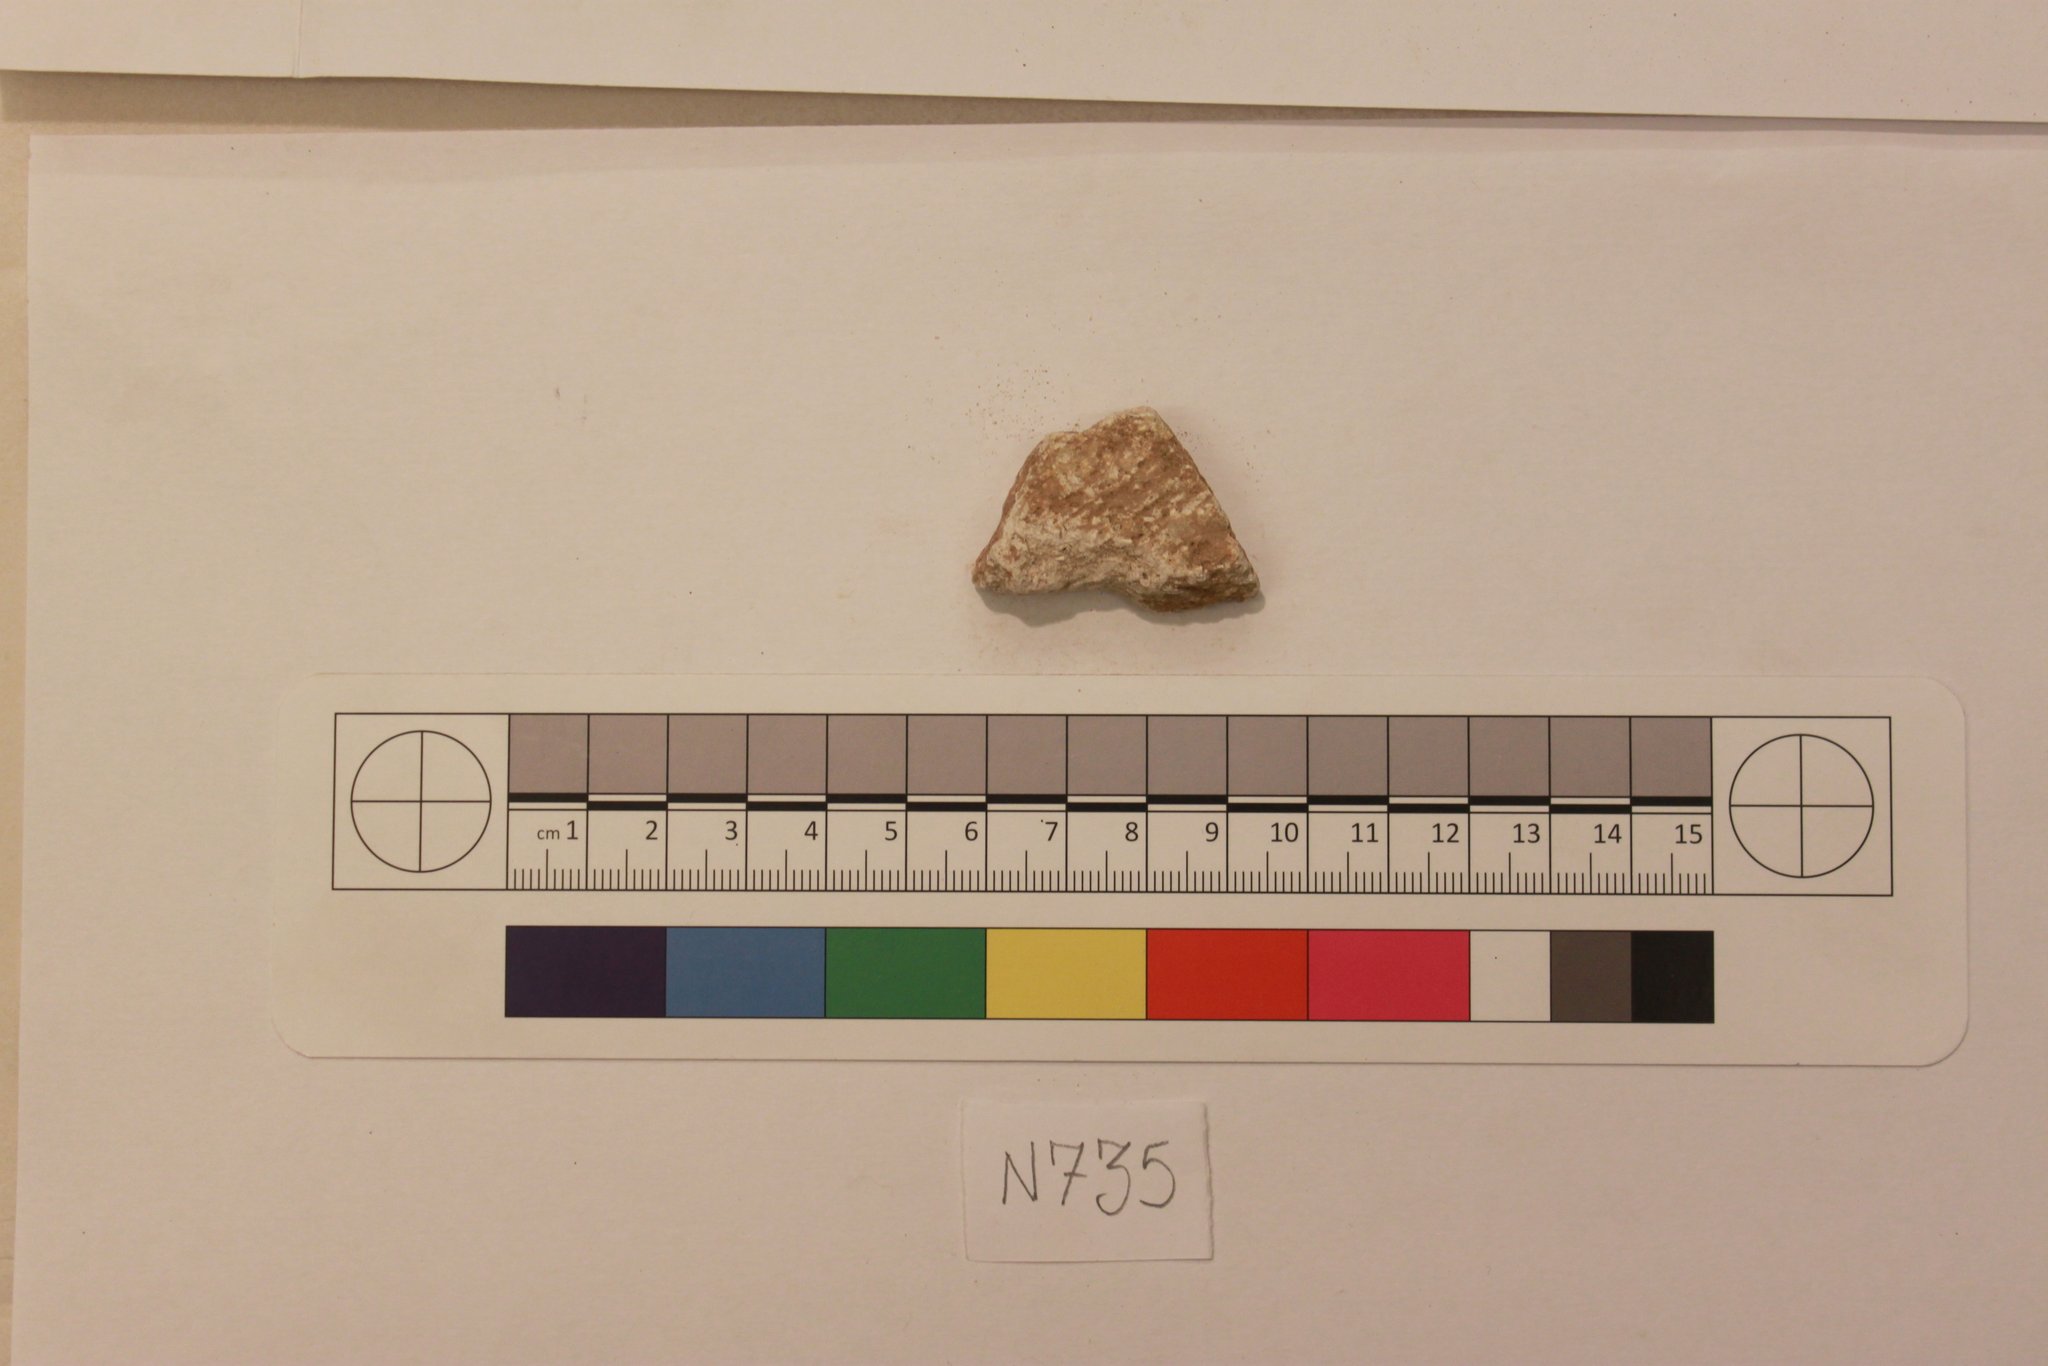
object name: fragment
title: Stucco Fragment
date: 701-1200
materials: plaster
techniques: carving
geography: iran